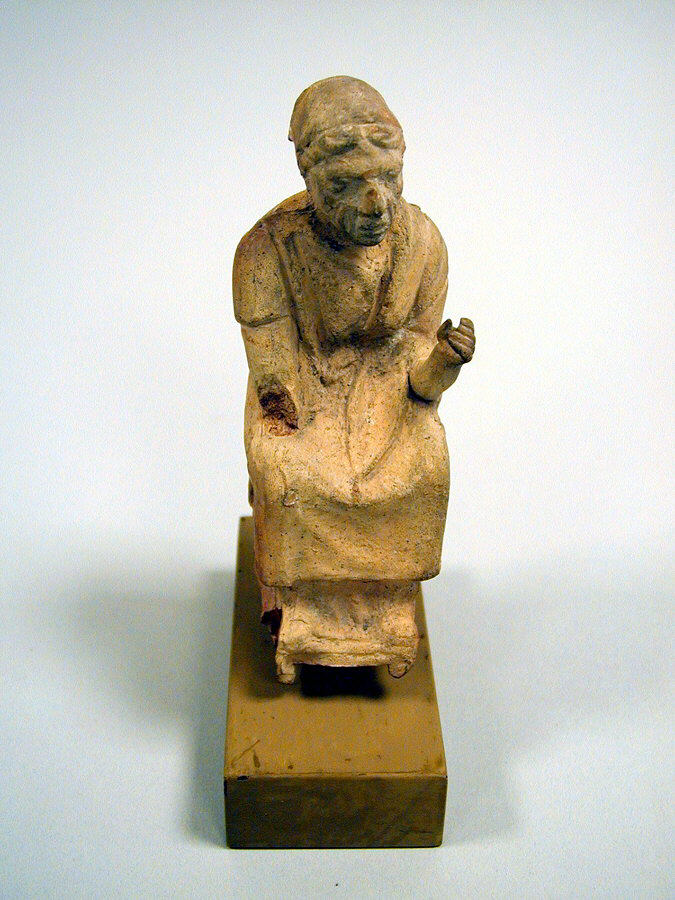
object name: statuette of a woman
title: Statuette of an old woman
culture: greek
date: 400-201 BCE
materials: terracotta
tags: women